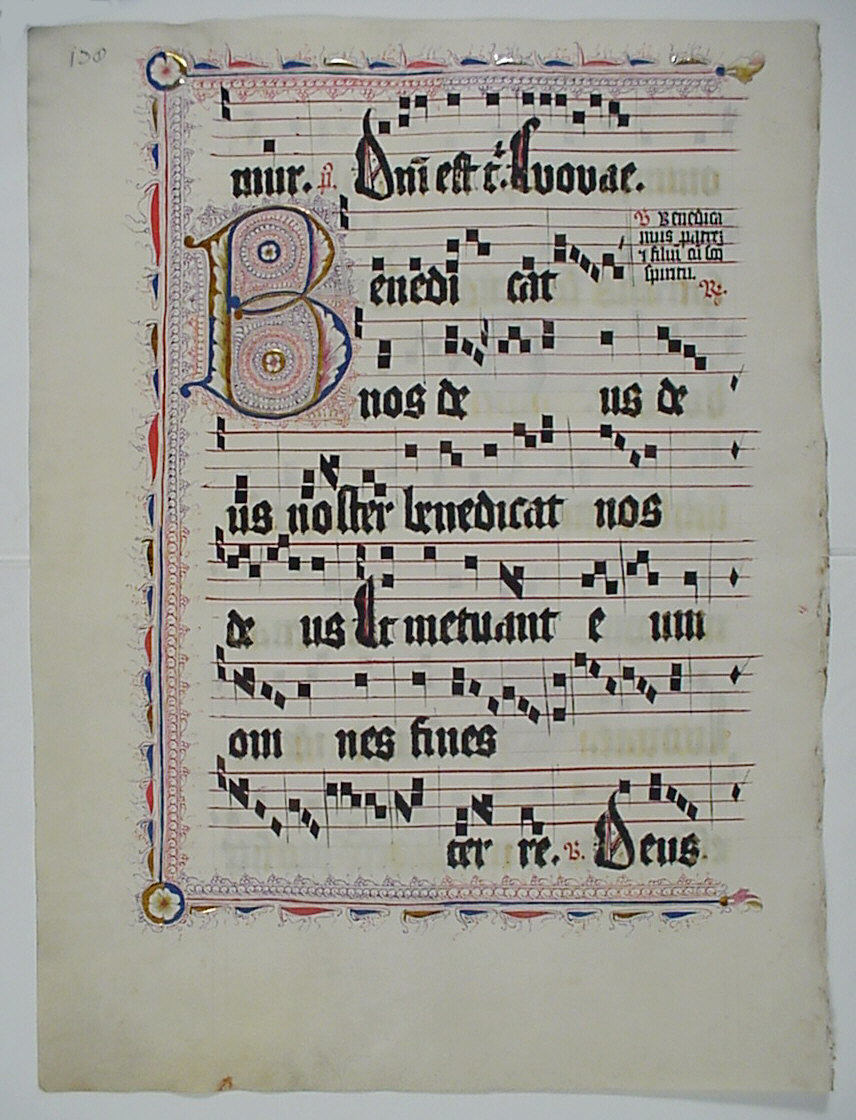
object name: antiphonary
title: Manuscript Leaf with Initial B, from an Antiphonary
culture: german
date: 1426-1450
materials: ink, metal leaf, parchment, paint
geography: germany